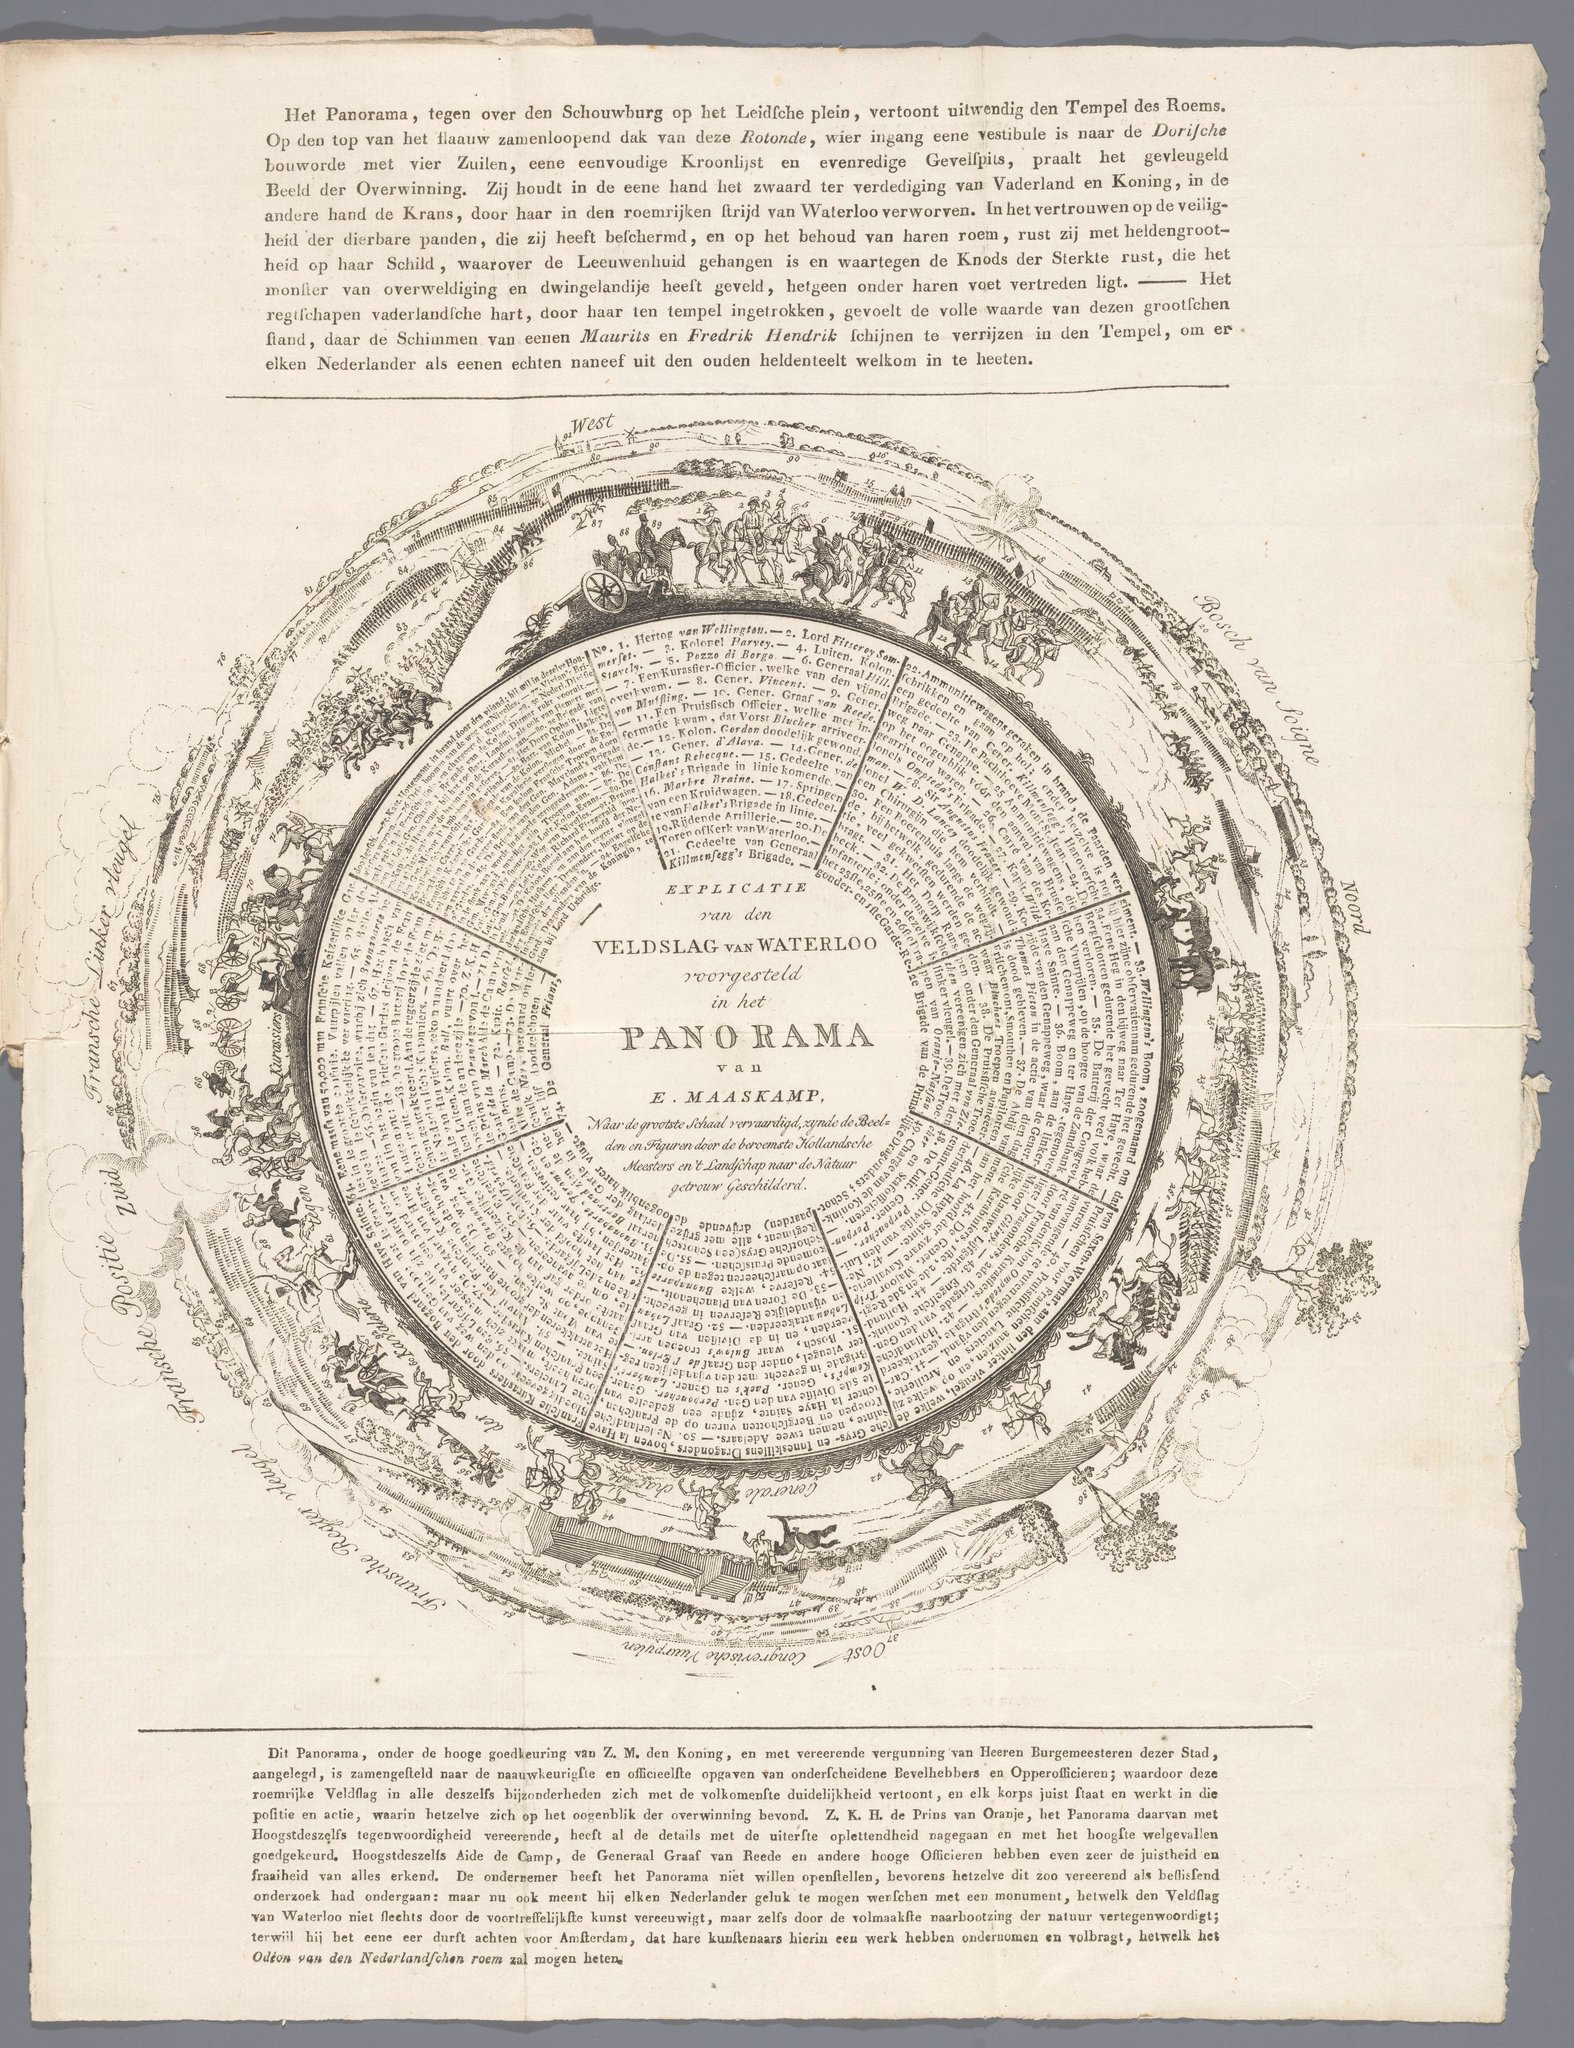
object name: print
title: Panorama van de Slag bij Waterloo, 1815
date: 1815-1816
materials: paper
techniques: etching, letterpress printing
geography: netherlands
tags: amsterdam, painter, print maker, draughtsman, publisher, evert maaskamp, panorama, cyclorama, picture, painting, battle (+ land forces), waterloo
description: Panorama van de Slag bij Waterloo van 18 juni 1815. Panorama opgericht door Evert Maaskamp op het Leidseplein te Amsterdam. Ronde voorstelling van de slag, met genummerde details, daarbinnen in acht compartimenten de legenda 1-94. Boven een beschrijving van de veldslag, onder een beschrijving van het panorama en van het bezoek van de prins van Oranje aan het schilderij.